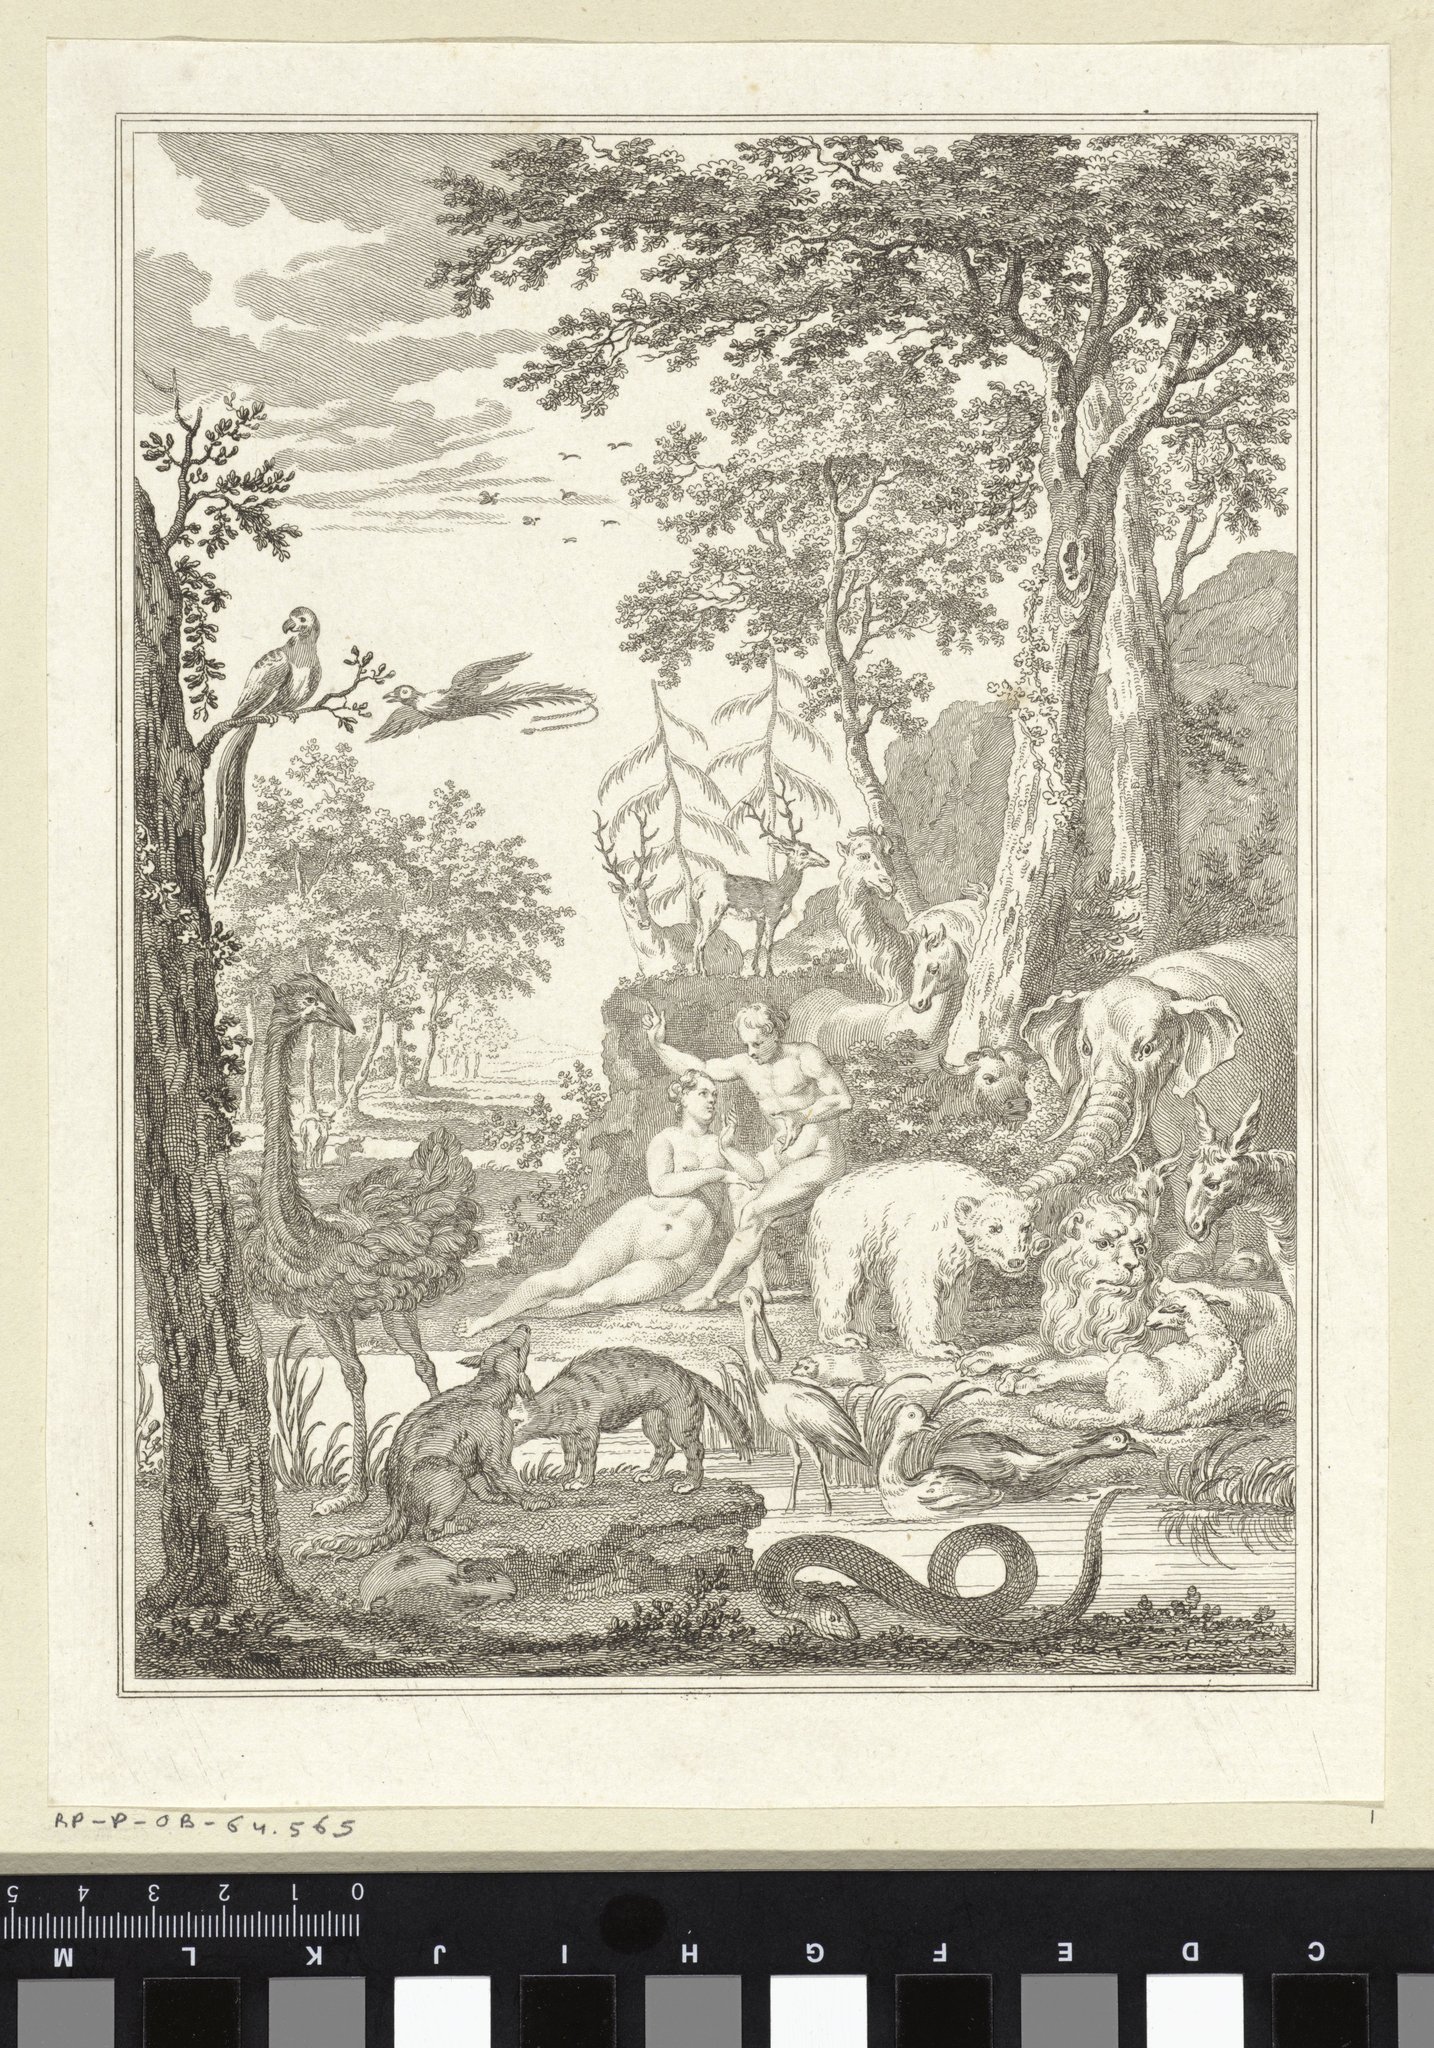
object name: print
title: Adam en Eva in het Paradijs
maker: reinier vinkeles (i)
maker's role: draughtsman, print maker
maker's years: 1741-1816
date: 1751-1808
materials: paper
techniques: etching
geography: amsterdam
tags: adam and eve in paradise (before the fall)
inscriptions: collector's mark: Lugt 240